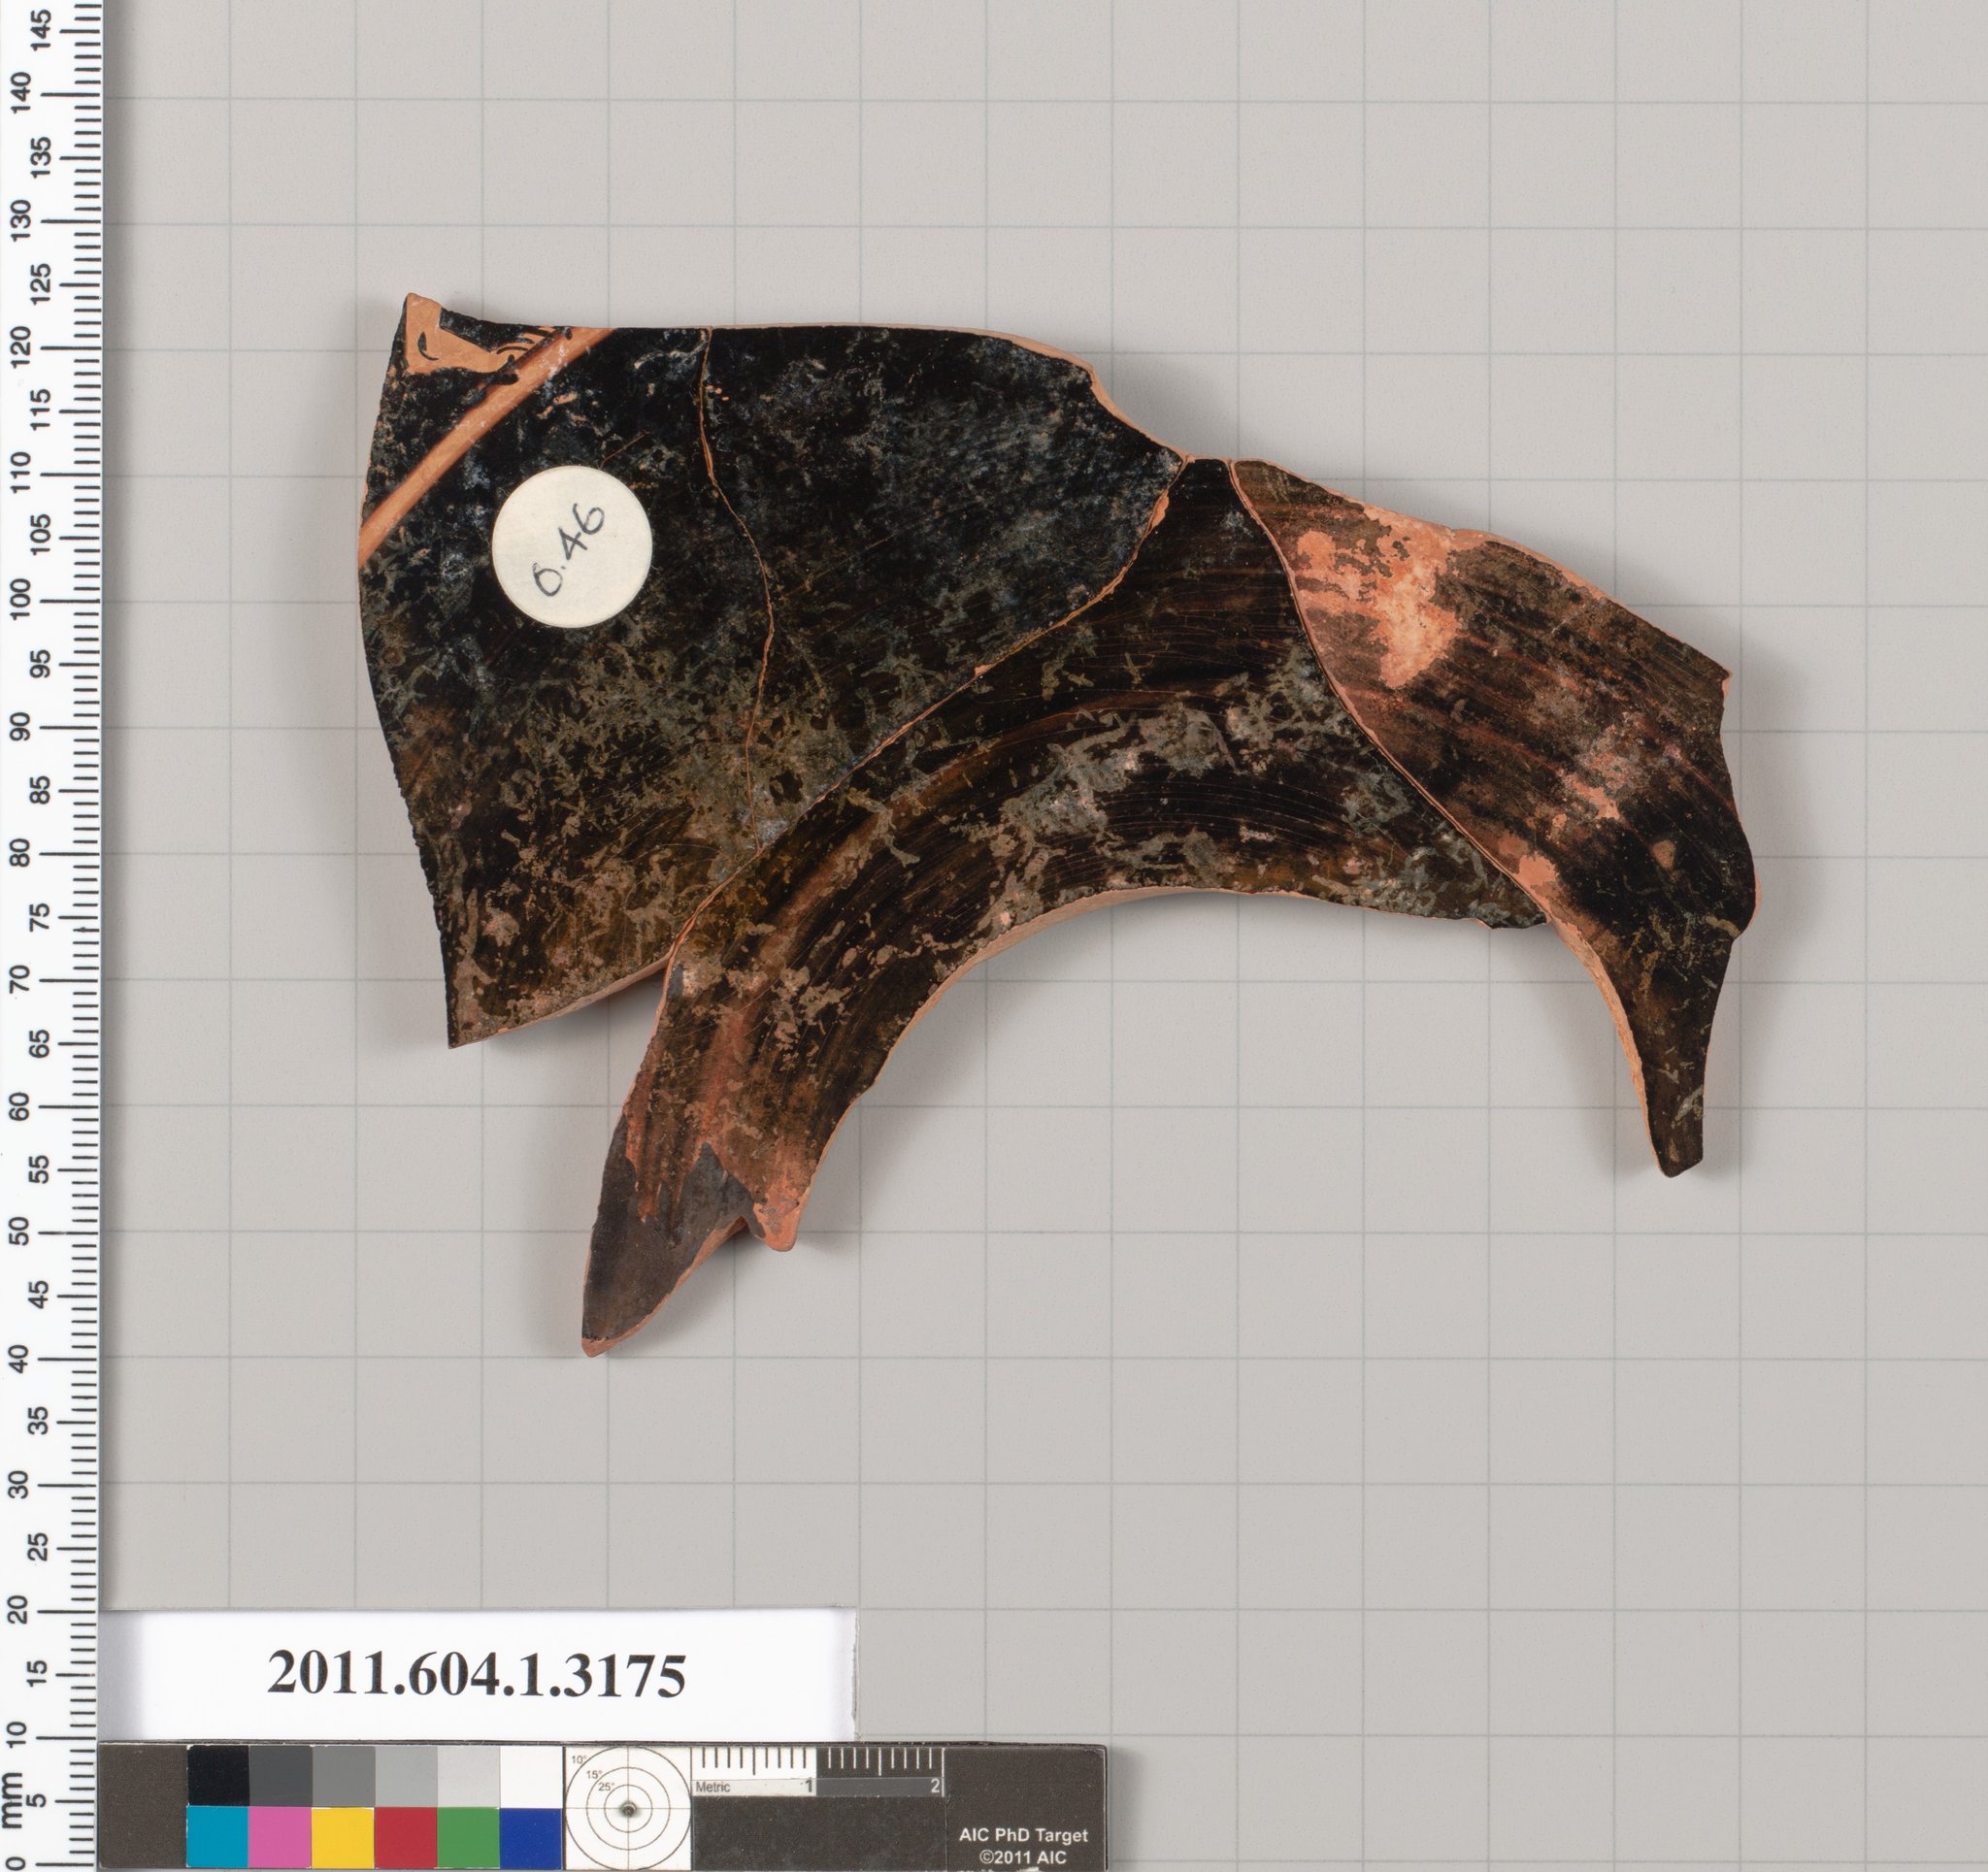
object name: kylix fragment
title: Terracotta fragment of a kylix (drinking cup)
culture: greek, attic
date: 500-490 BCE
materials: terracotta